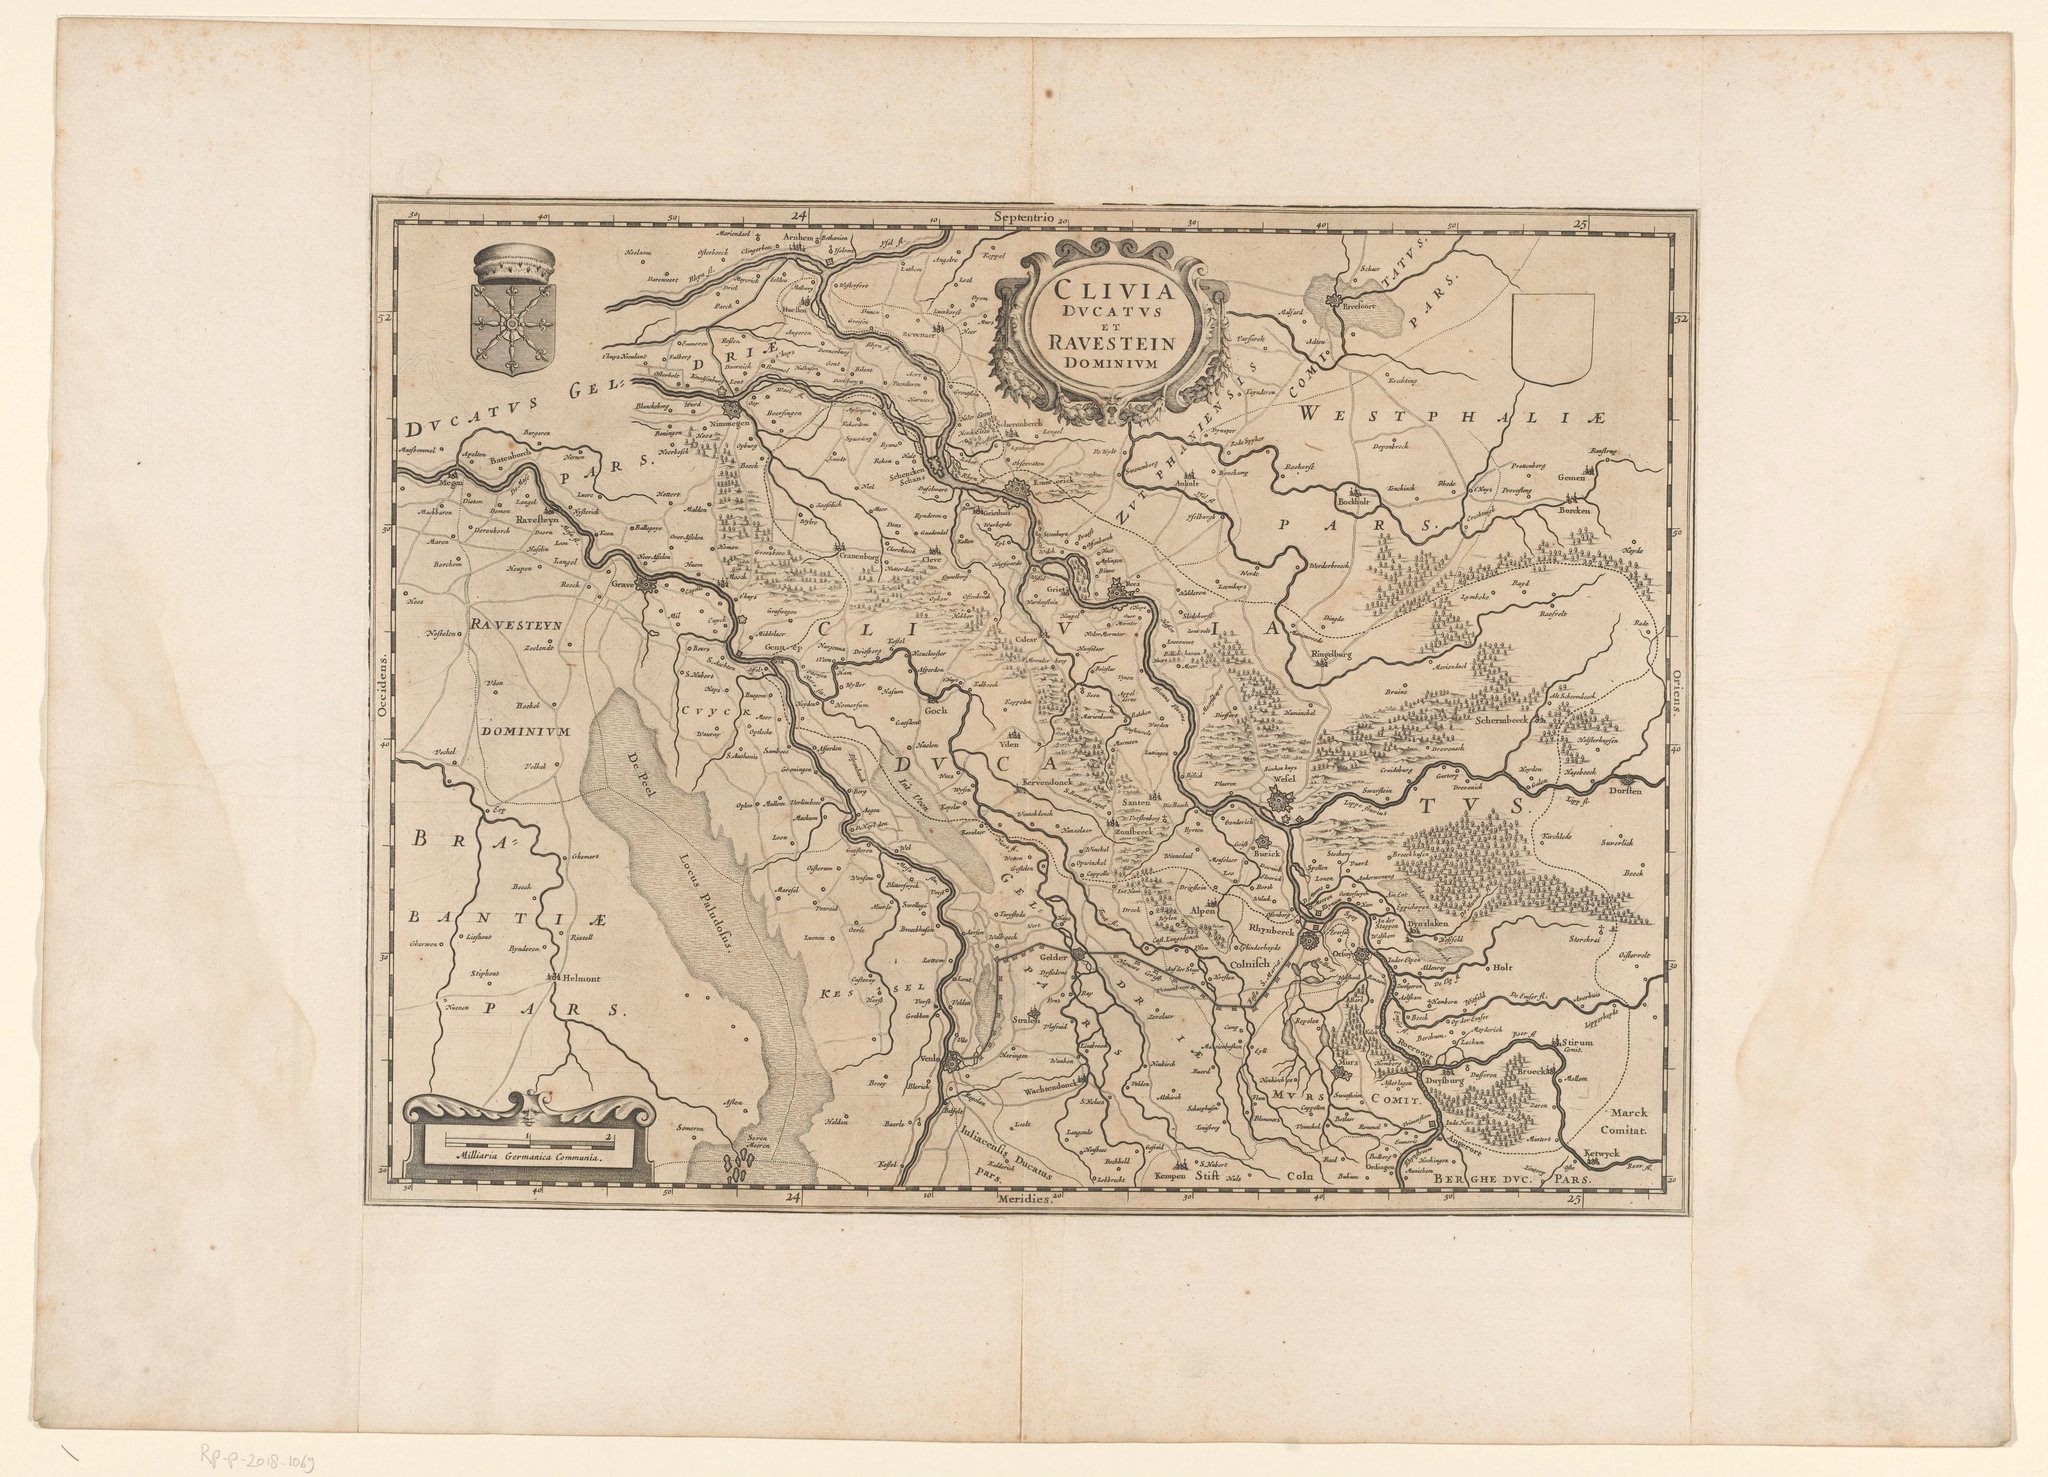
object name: map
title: Clivia ducatus et Ravestein dominium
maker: Anonymous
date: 1630-1680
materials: paper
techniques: engraving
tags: coat of arms (as symbol of the state, etc.) (+ city; municipal), maps of separate countries or regions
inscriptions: collector's mark: Lugt 2228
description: Linksboven het wapen van het hertogdom Kleef.